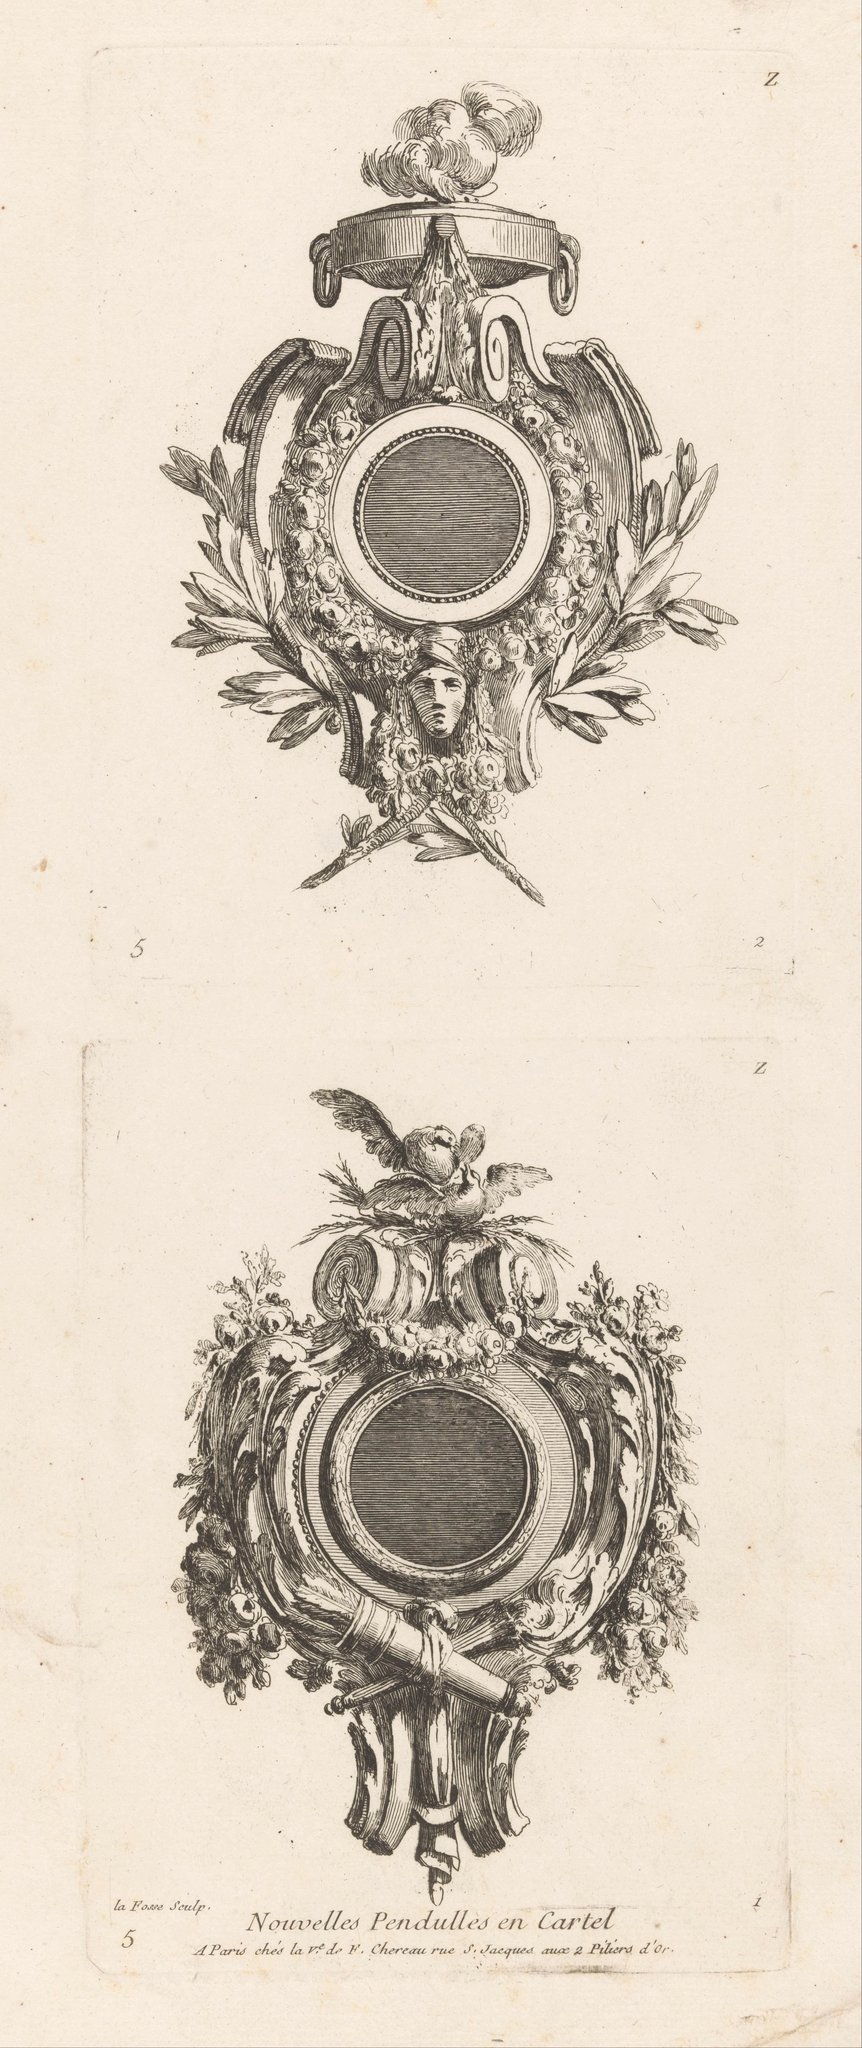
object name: ornament print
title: IIe Volume De l'Oeuvre de J. Ch. Delafosse (...)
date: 1771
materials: paper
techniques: etching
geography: paris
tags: clock, flowers ~ ornament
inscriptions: collector's mark: Lugt 2760, collector's mark: Lugt 2228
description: Twee pendules op een blad. Boven een pendule met bloemen, een rookvat en een masker. Onder een pendule met bloemen, een fakkel, een pijlenkoker en vogels. Links onder 5 genummerd.